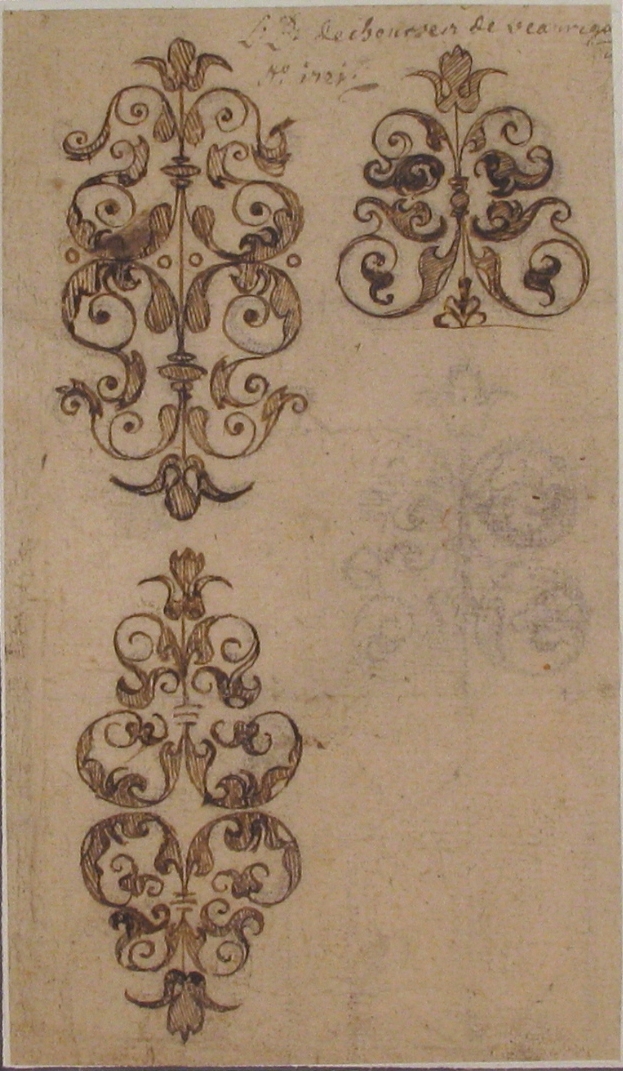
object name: drawing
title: Designs for Ornament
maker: anonymous, french, 18th century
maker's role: artist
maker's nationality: french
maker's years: 1700-1800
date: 1721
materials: chalk, ink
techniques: pen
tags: ornament